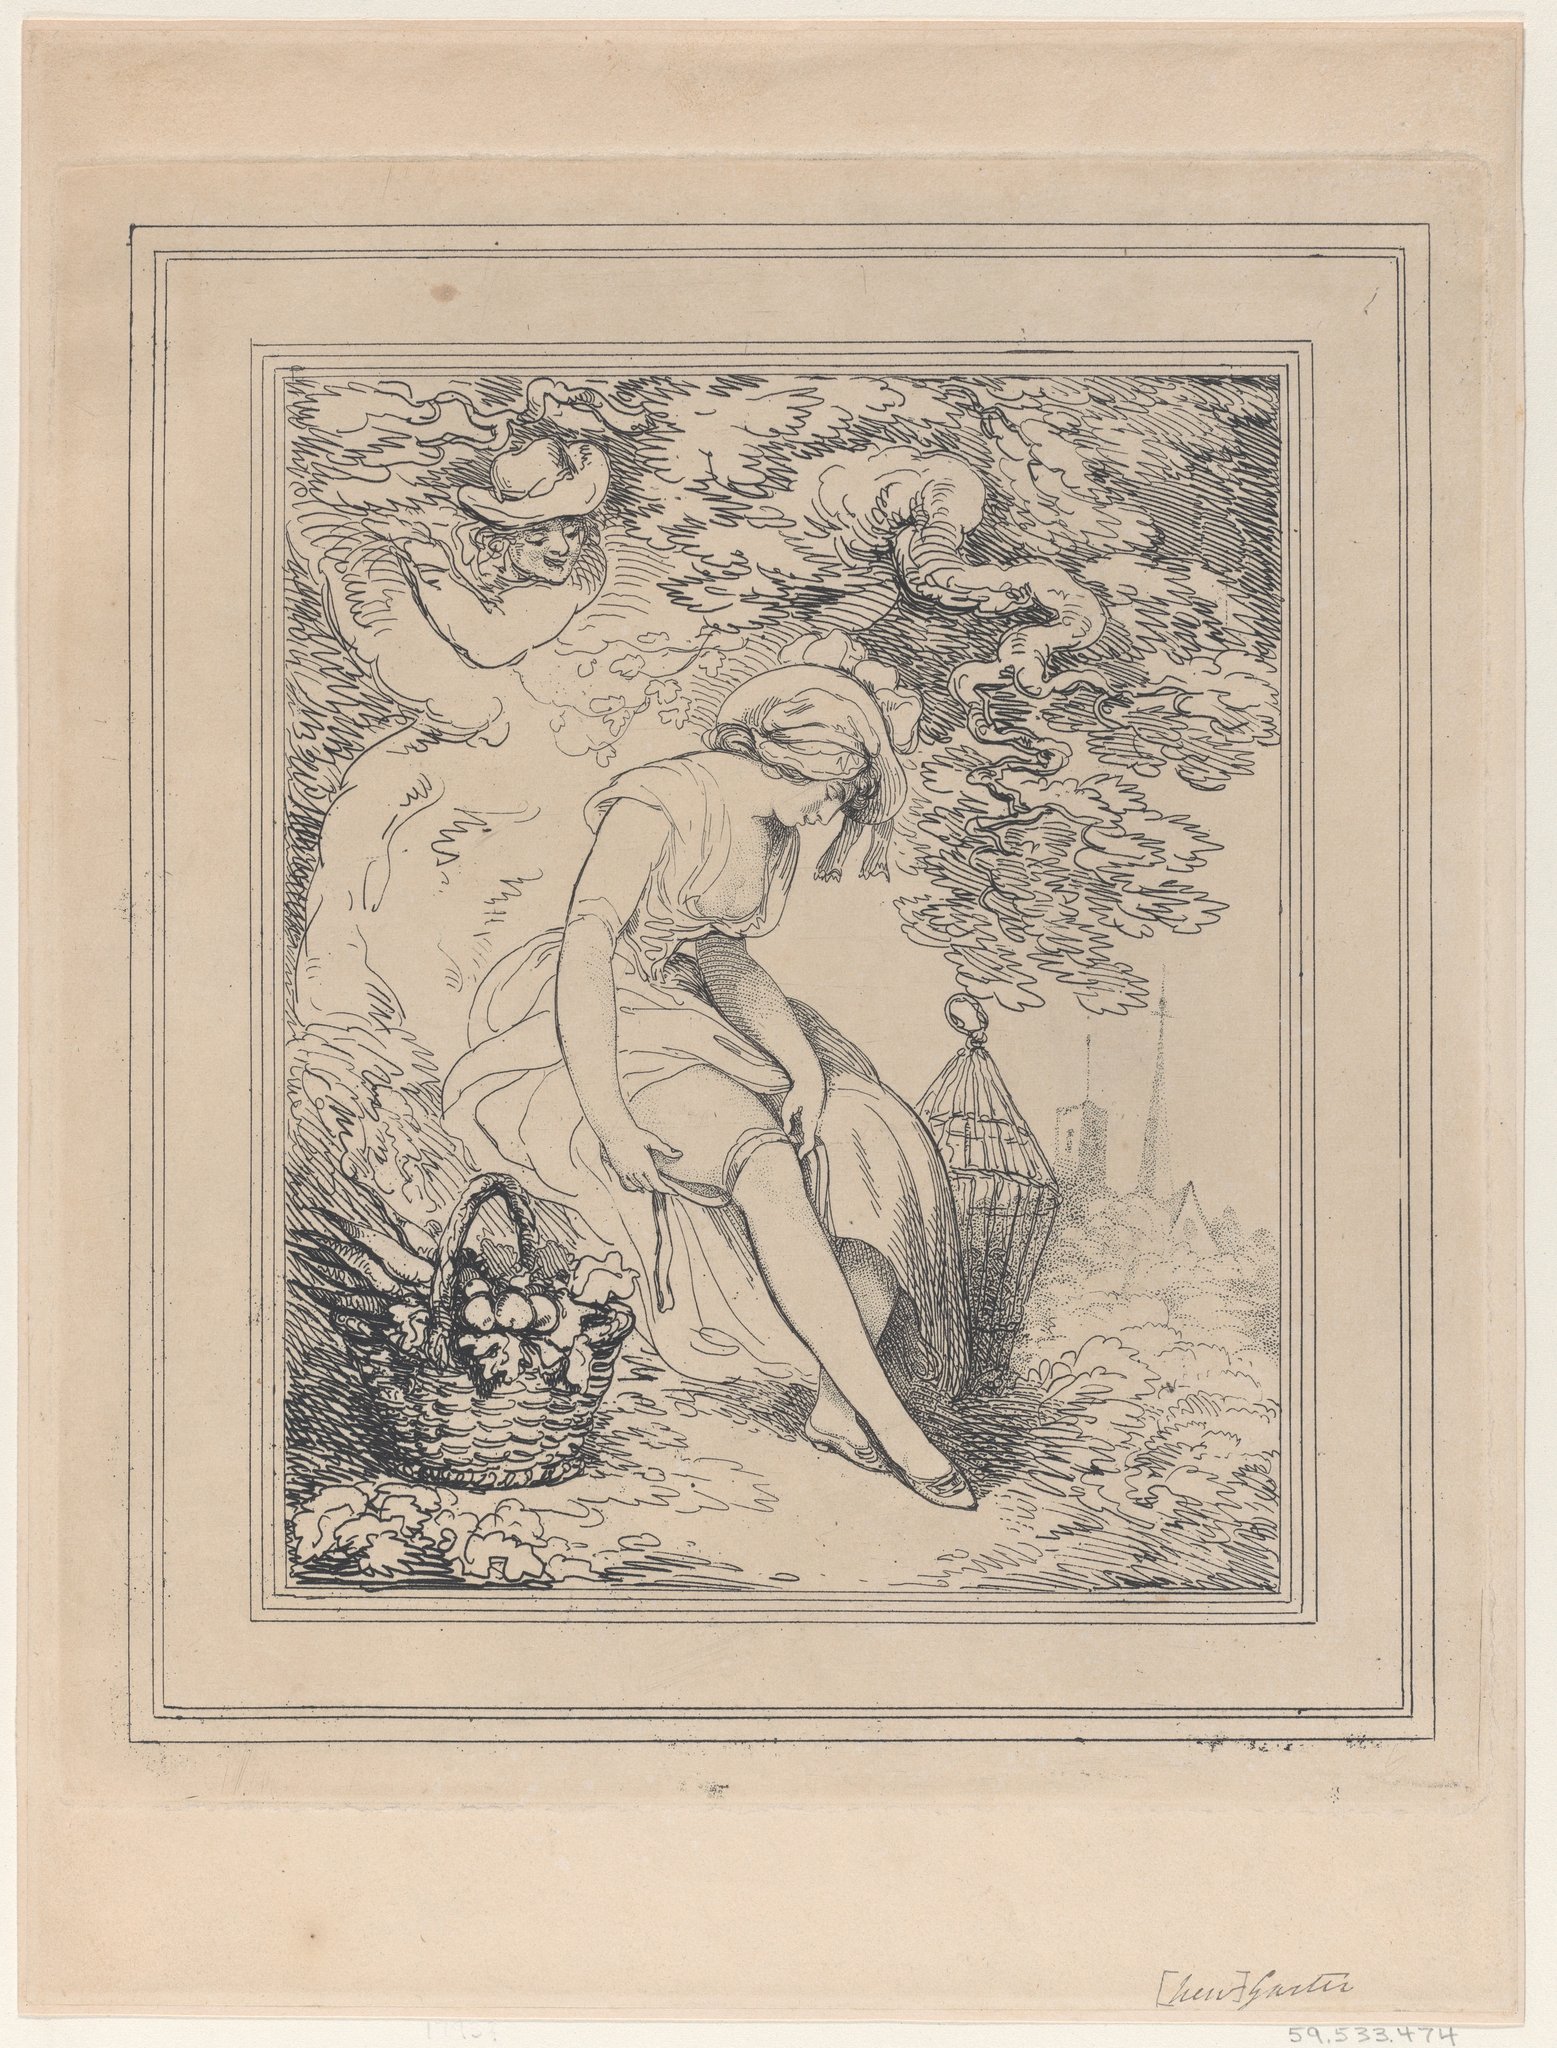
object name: print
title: Girl with a Basket and Birdcage Adjusting Her Garter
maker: thomas rowlandson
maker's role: artist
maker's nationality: british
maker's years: 1757-1827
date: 1785-1795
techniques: etching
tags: men,women